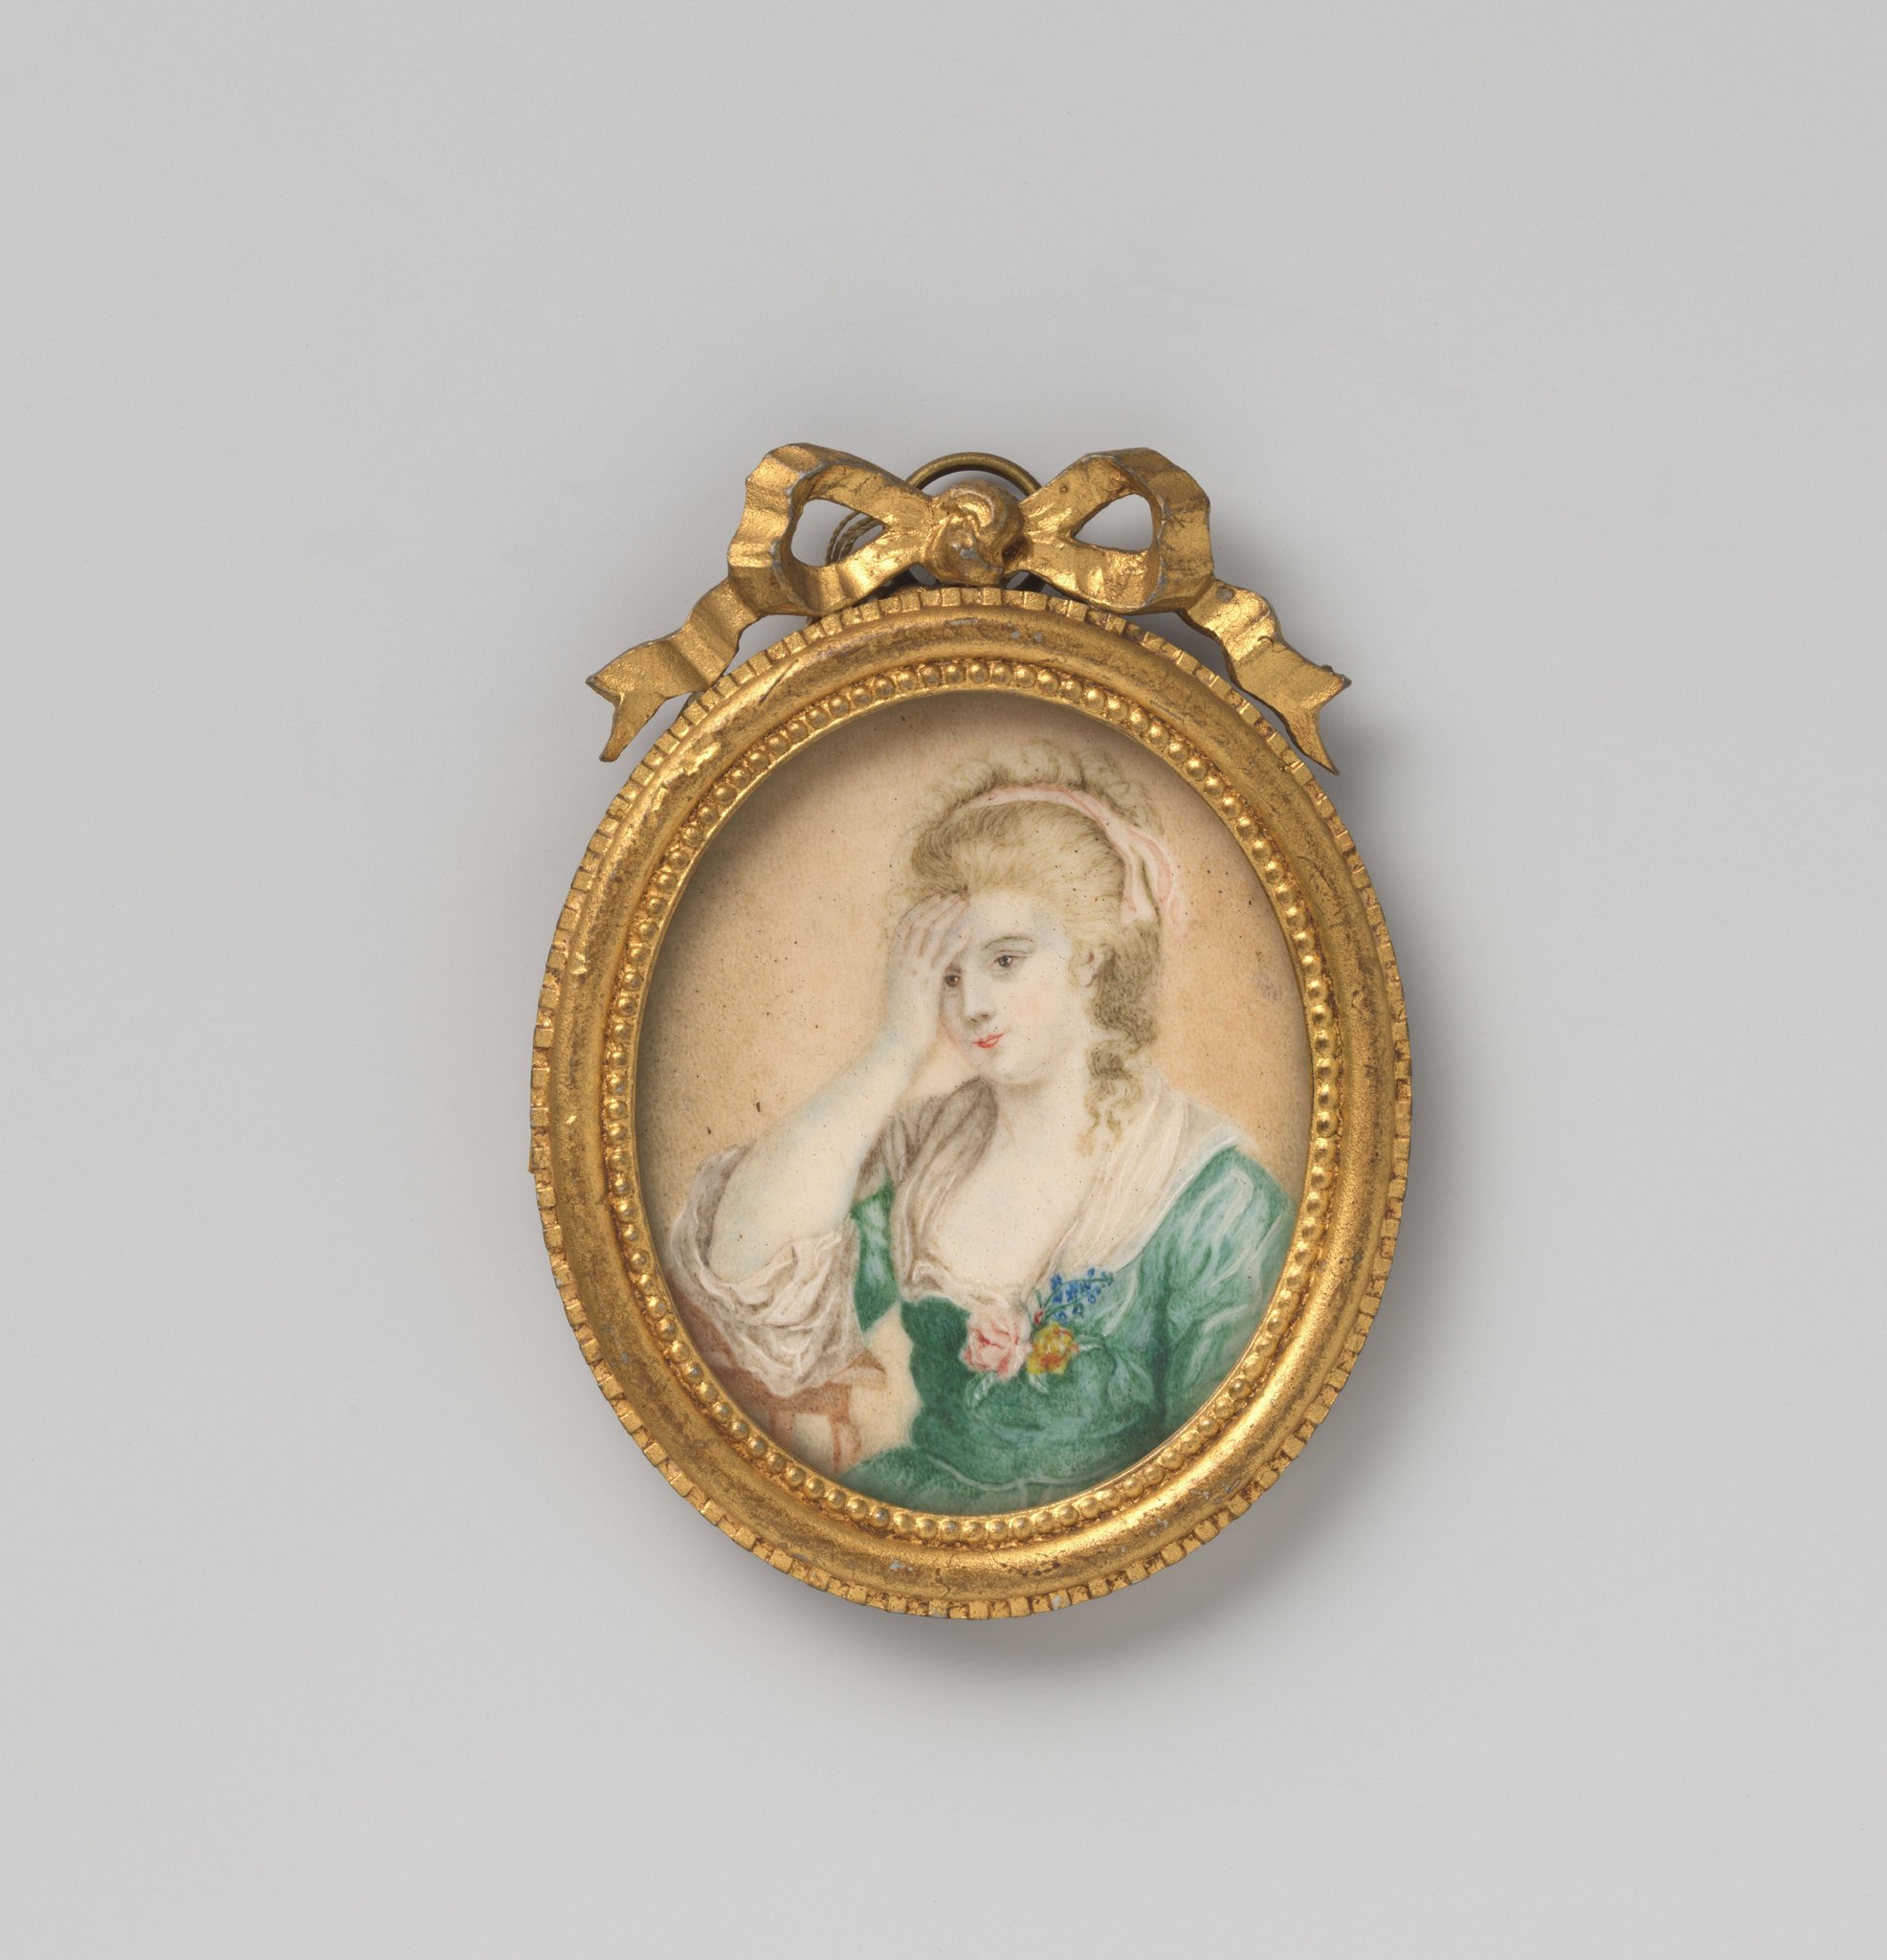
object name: miniature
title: Schilderij met voorstelling van een vrouw met sluier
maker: Anonymous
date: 1850-1899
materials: alloy, glass, gold, gouache, ivory, lead, paper, tin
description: Schilderij met voorstelling van een vrouw met sluier, miniatuur op ivoor. De vrouw is afgebeeld in profiel, naar links kijkend, gekleed in een zwarte jurk met witte omslagdoek, afgezet met kant en een doorzichtige sluier met kant gedrapeerd over hoog opgestoken donker haar. Gevat in een ovale lijst van metaal in neo-klassicistische stijl met parel- en ribbelrand, bekroond door een strik.